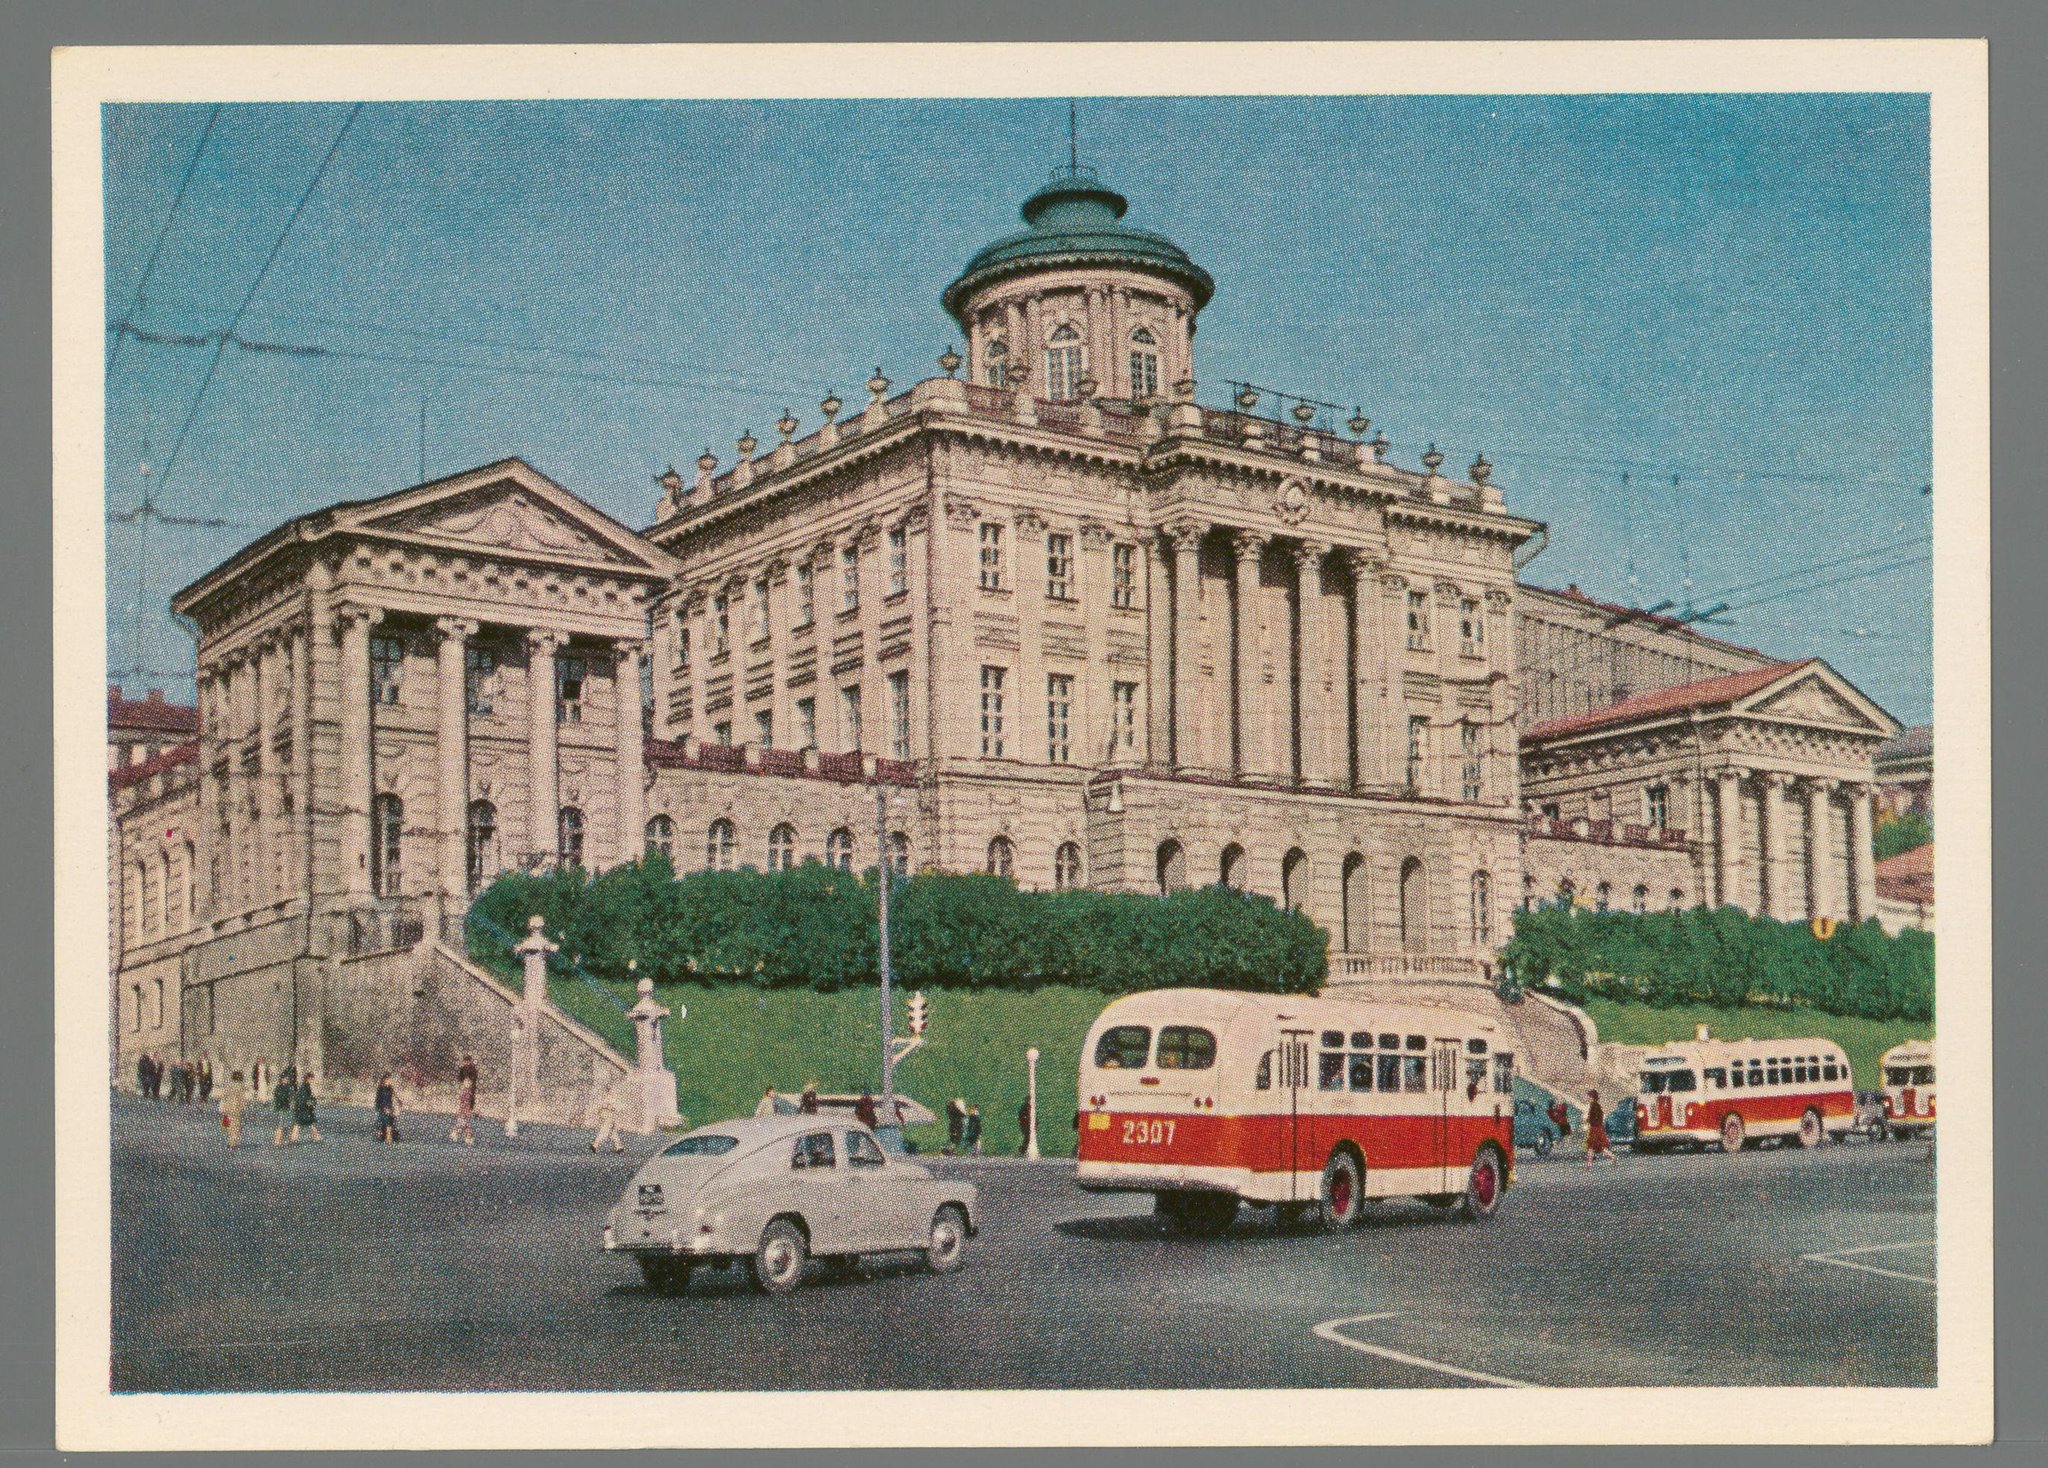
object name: photomechanical print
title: Moscow. The Lenin State Library. (The old building) / Moskau. Staatliche Lenin-Bibliothek (altes Gebäude) / Moscou. La Bibliothèque Lénine (ancien bâtiment)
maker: Anonymous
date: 1956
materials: cardboard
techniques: color autotype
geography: moscow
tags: public library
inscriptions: date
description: De titel op object staat ook in het Russisch.